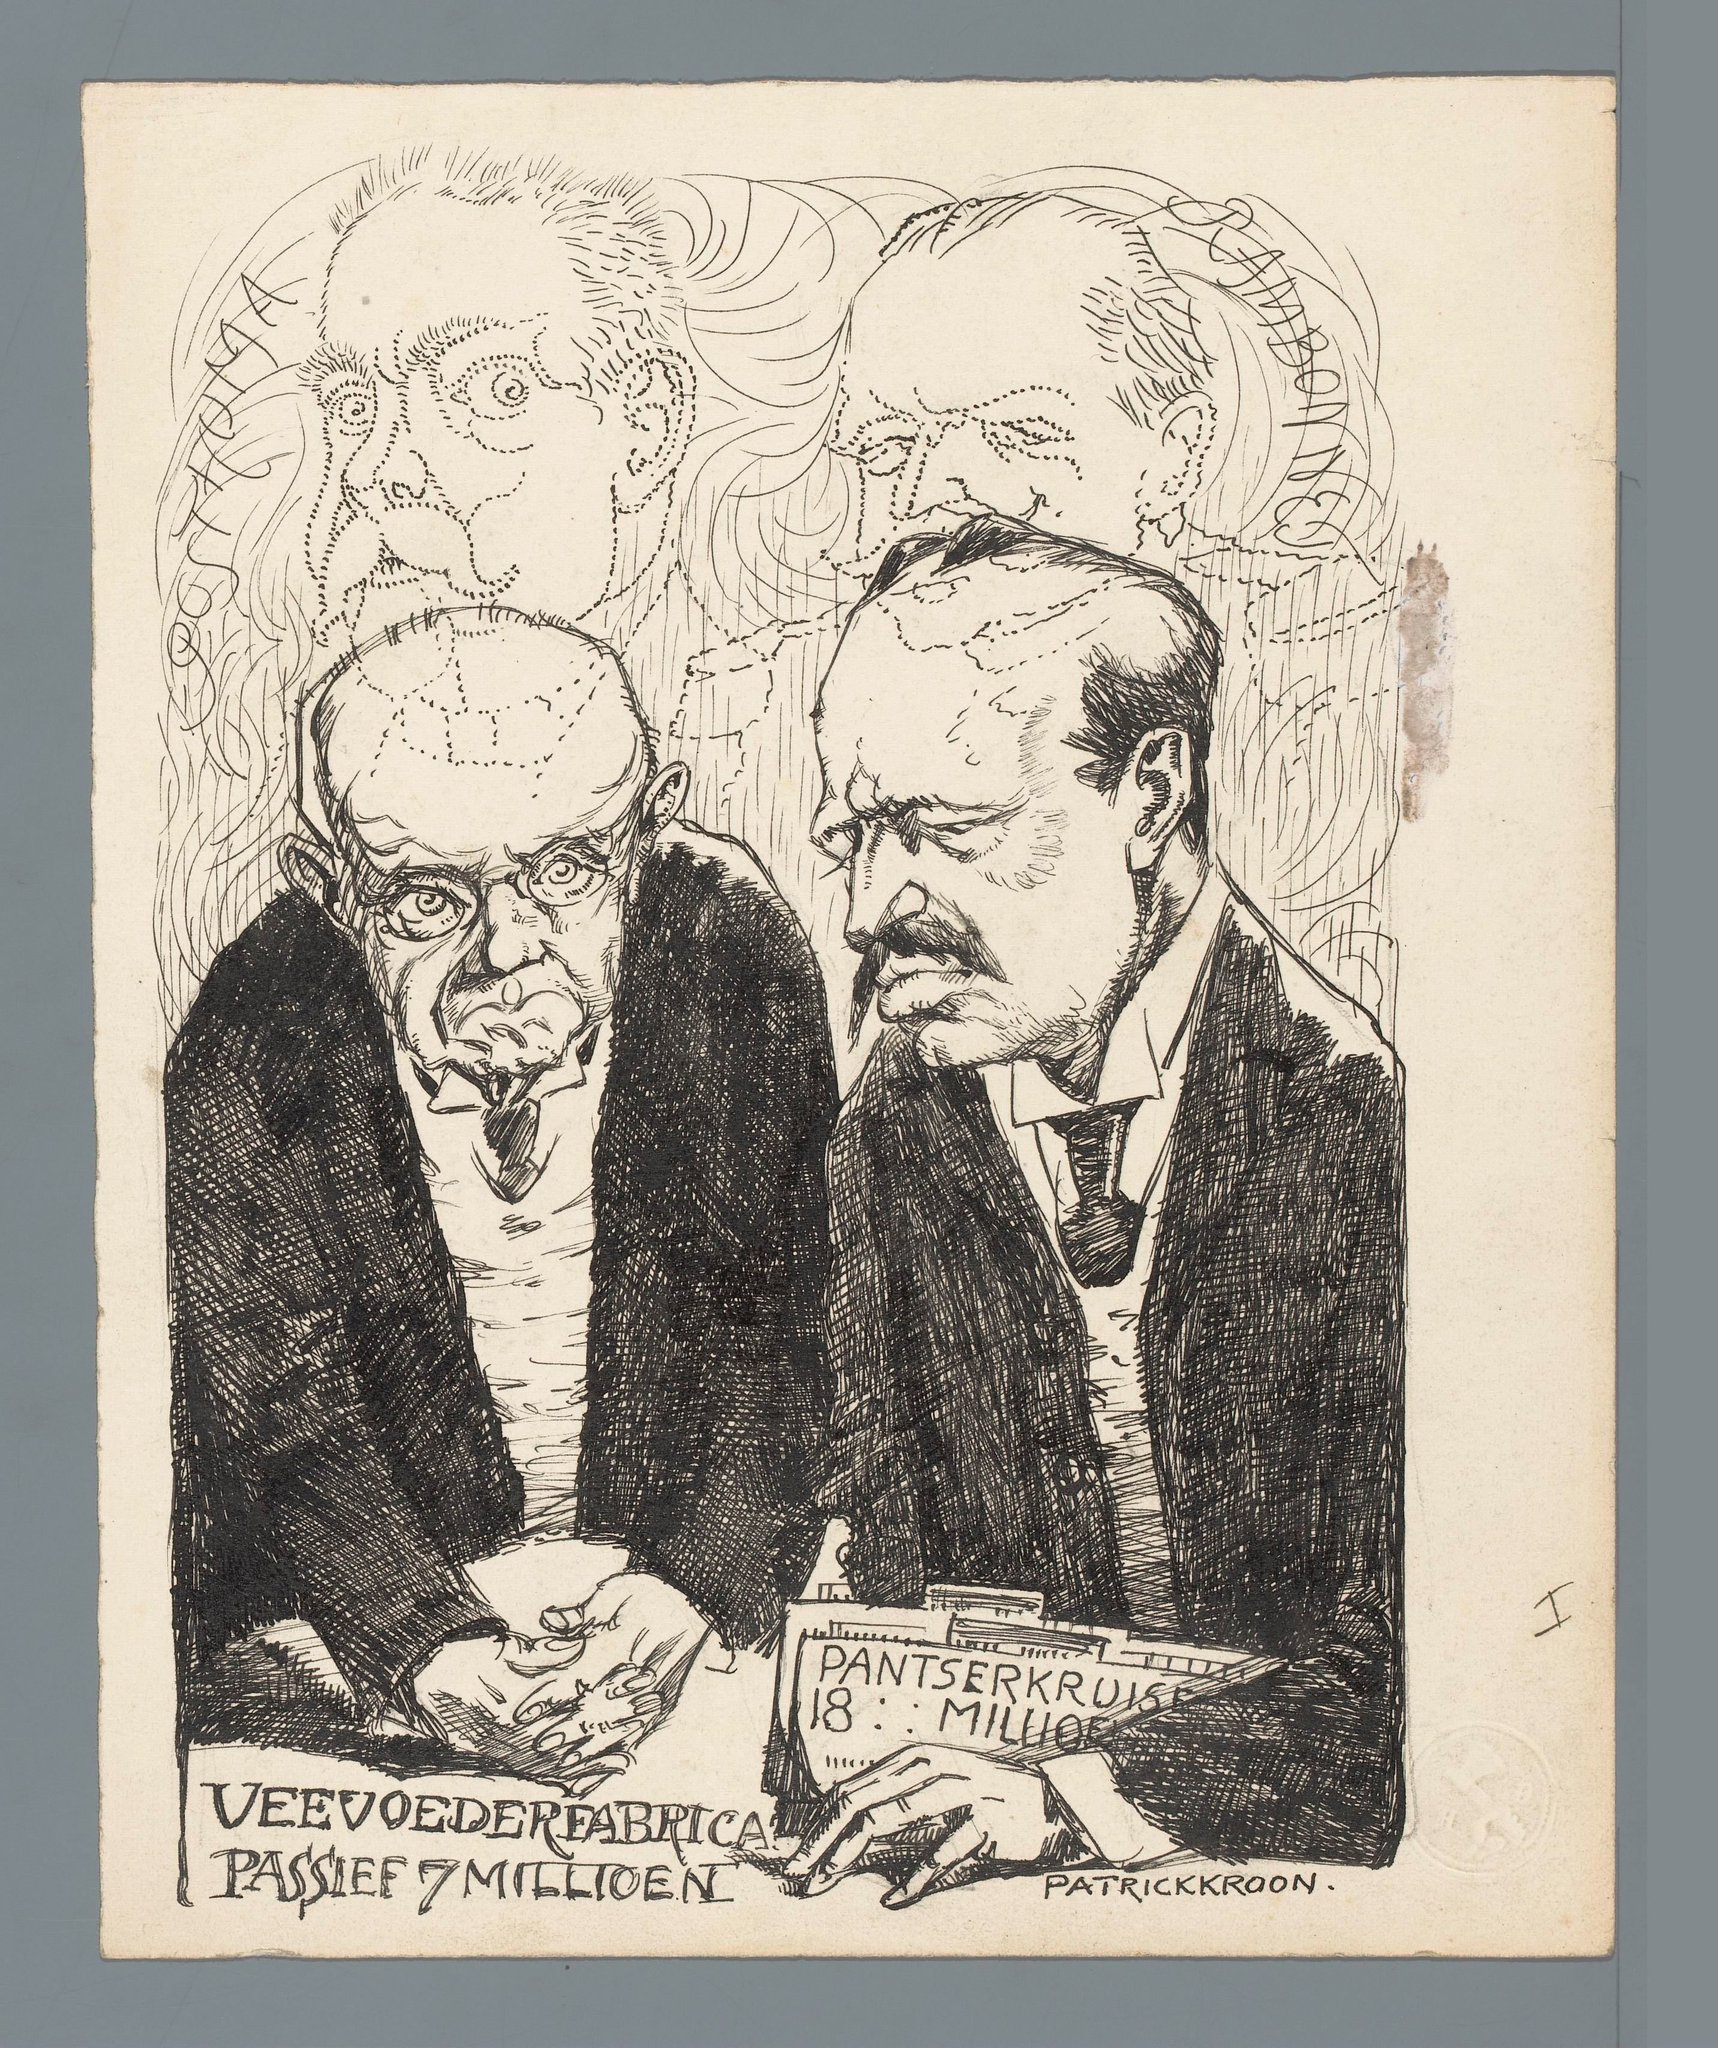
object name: cartoon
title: Twee Ministers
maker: patricq kroon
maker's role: draughtsman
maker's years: 1862-1941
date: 1920-1930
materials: ink, paper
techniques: pen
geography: netherlands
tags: wijhe, politician, minister ~ government, political caricatures and satires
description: Twee ministers, elk met een duur dossier: veevoederfabriek en pantserkruiser. Boven hen geesten van voorgangers (Posthuma en Rambonnet). Ontwerp voor een politieke spotprent.